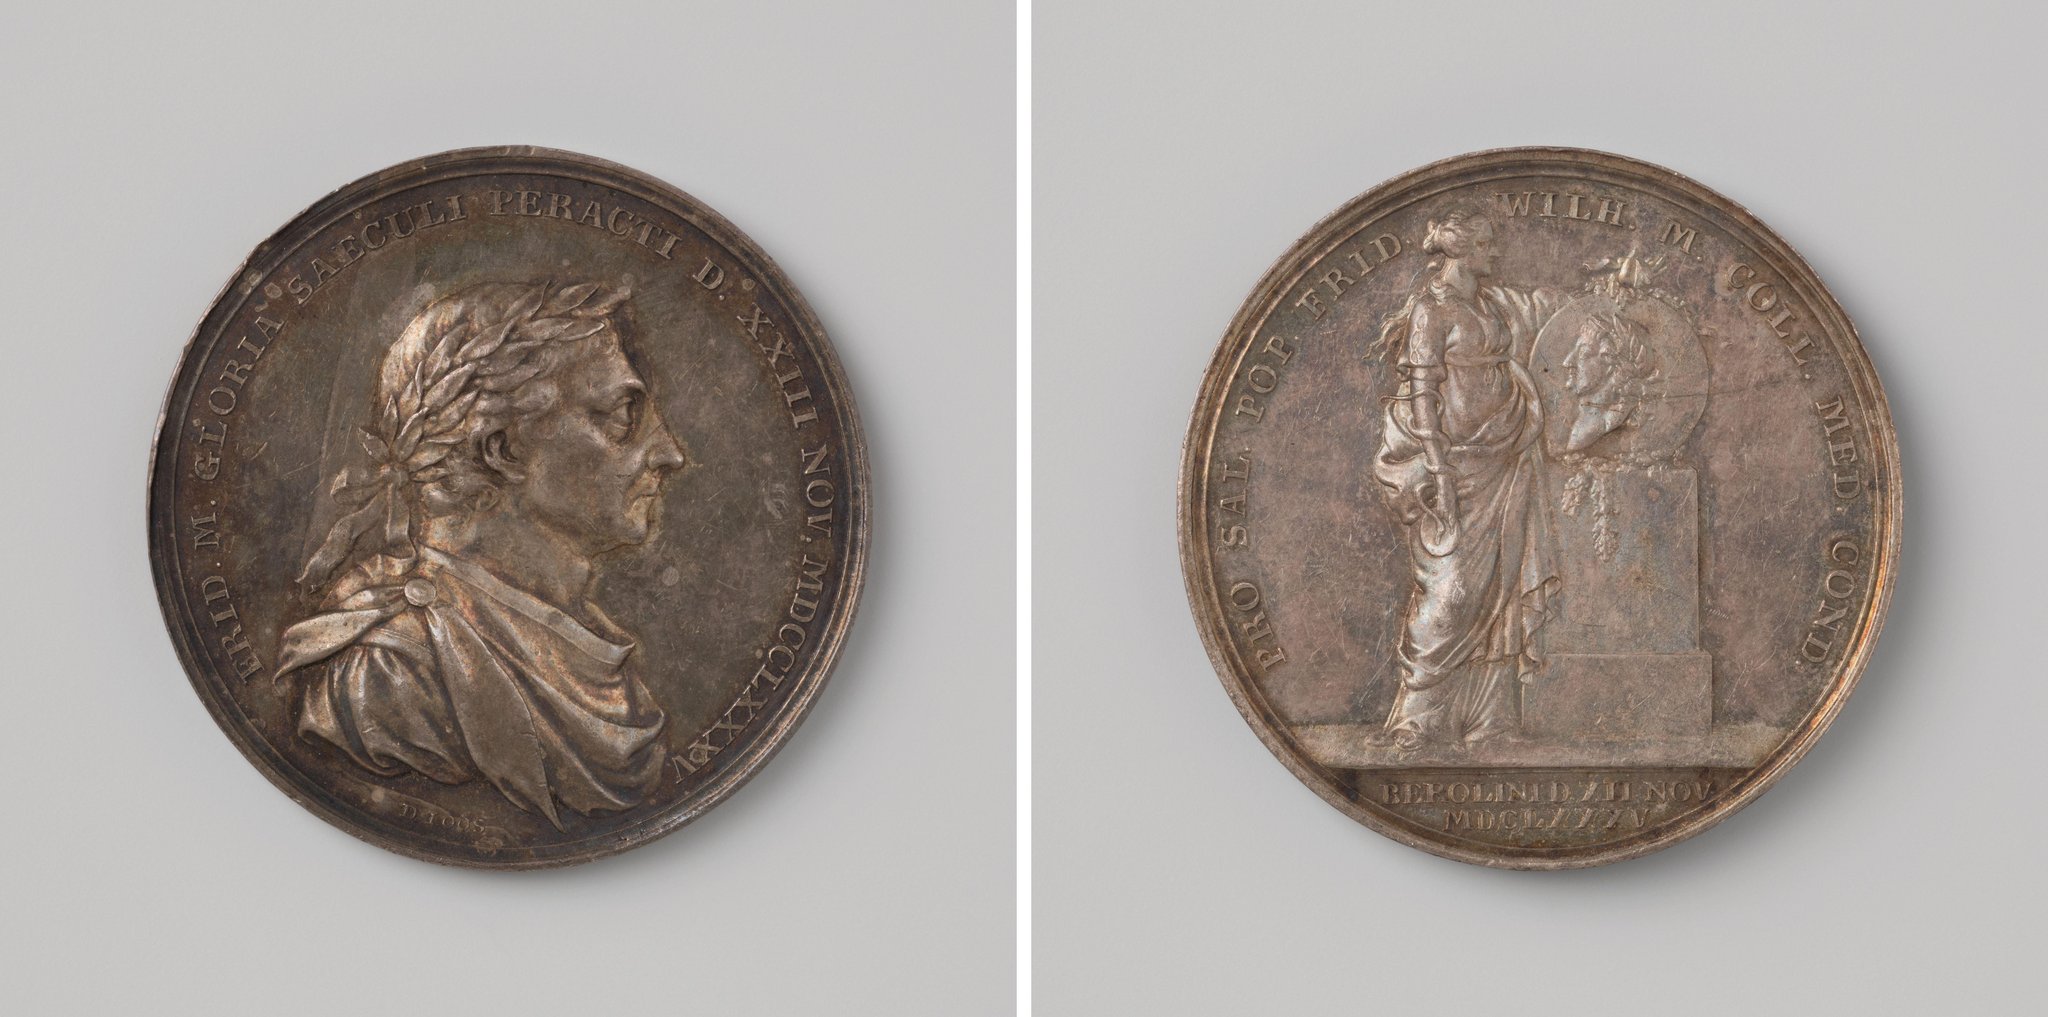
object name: history medal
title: Eeuwfeest van het Collegium Medicum te Berlijn, ter ere van Frederik II de Grote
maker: daniel friedrich loos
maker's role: medailleur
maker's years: 1735-1819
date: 1785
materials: silver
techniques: striking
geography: berlin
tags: frederik willem van brandenburg (i), berlin, frederick ii (king of prussia)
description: Zilveren penning. Voorzijde: borststuk man met lauwerkrans binnen omschrift. Keerzijde: vrouw met slang om arm gekronkeld en spiegel [?] in hand houdt portretmedaillon, omhangen met bladerloof op een voetstuk binnen omschrift; afsnede: opschrift